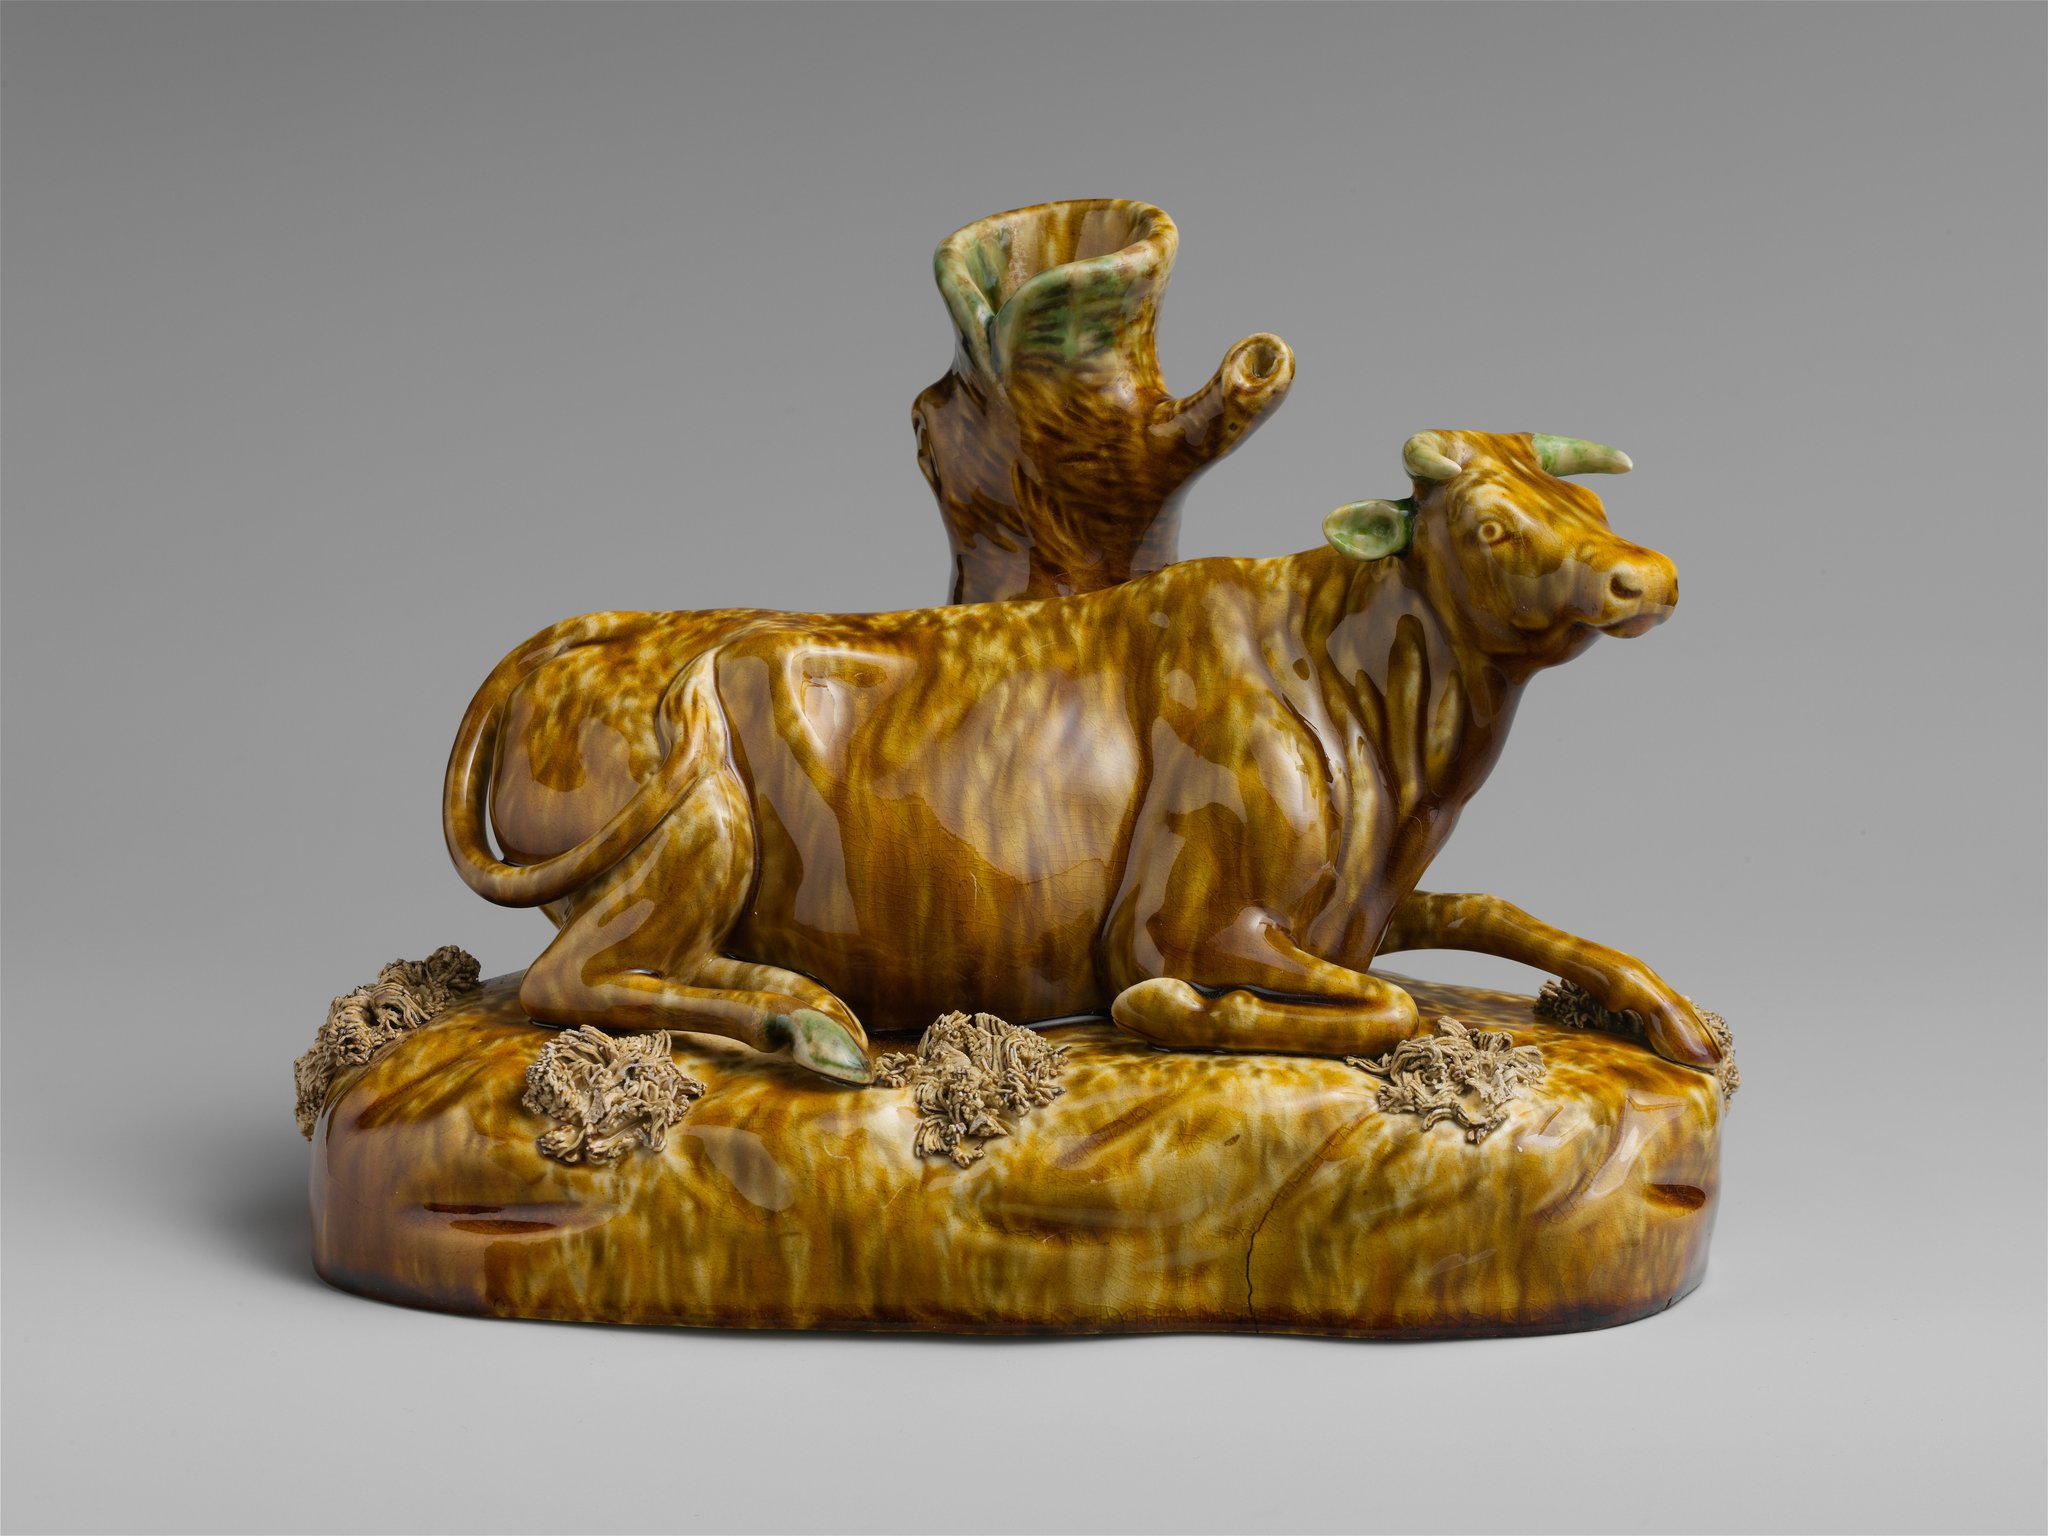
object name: figure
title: Recumbant cow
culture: american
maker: lyman, fenton & co.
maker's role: manufacturer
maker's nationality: american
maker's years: 1849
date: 1849-1852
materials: earthenware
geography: united states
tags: cows